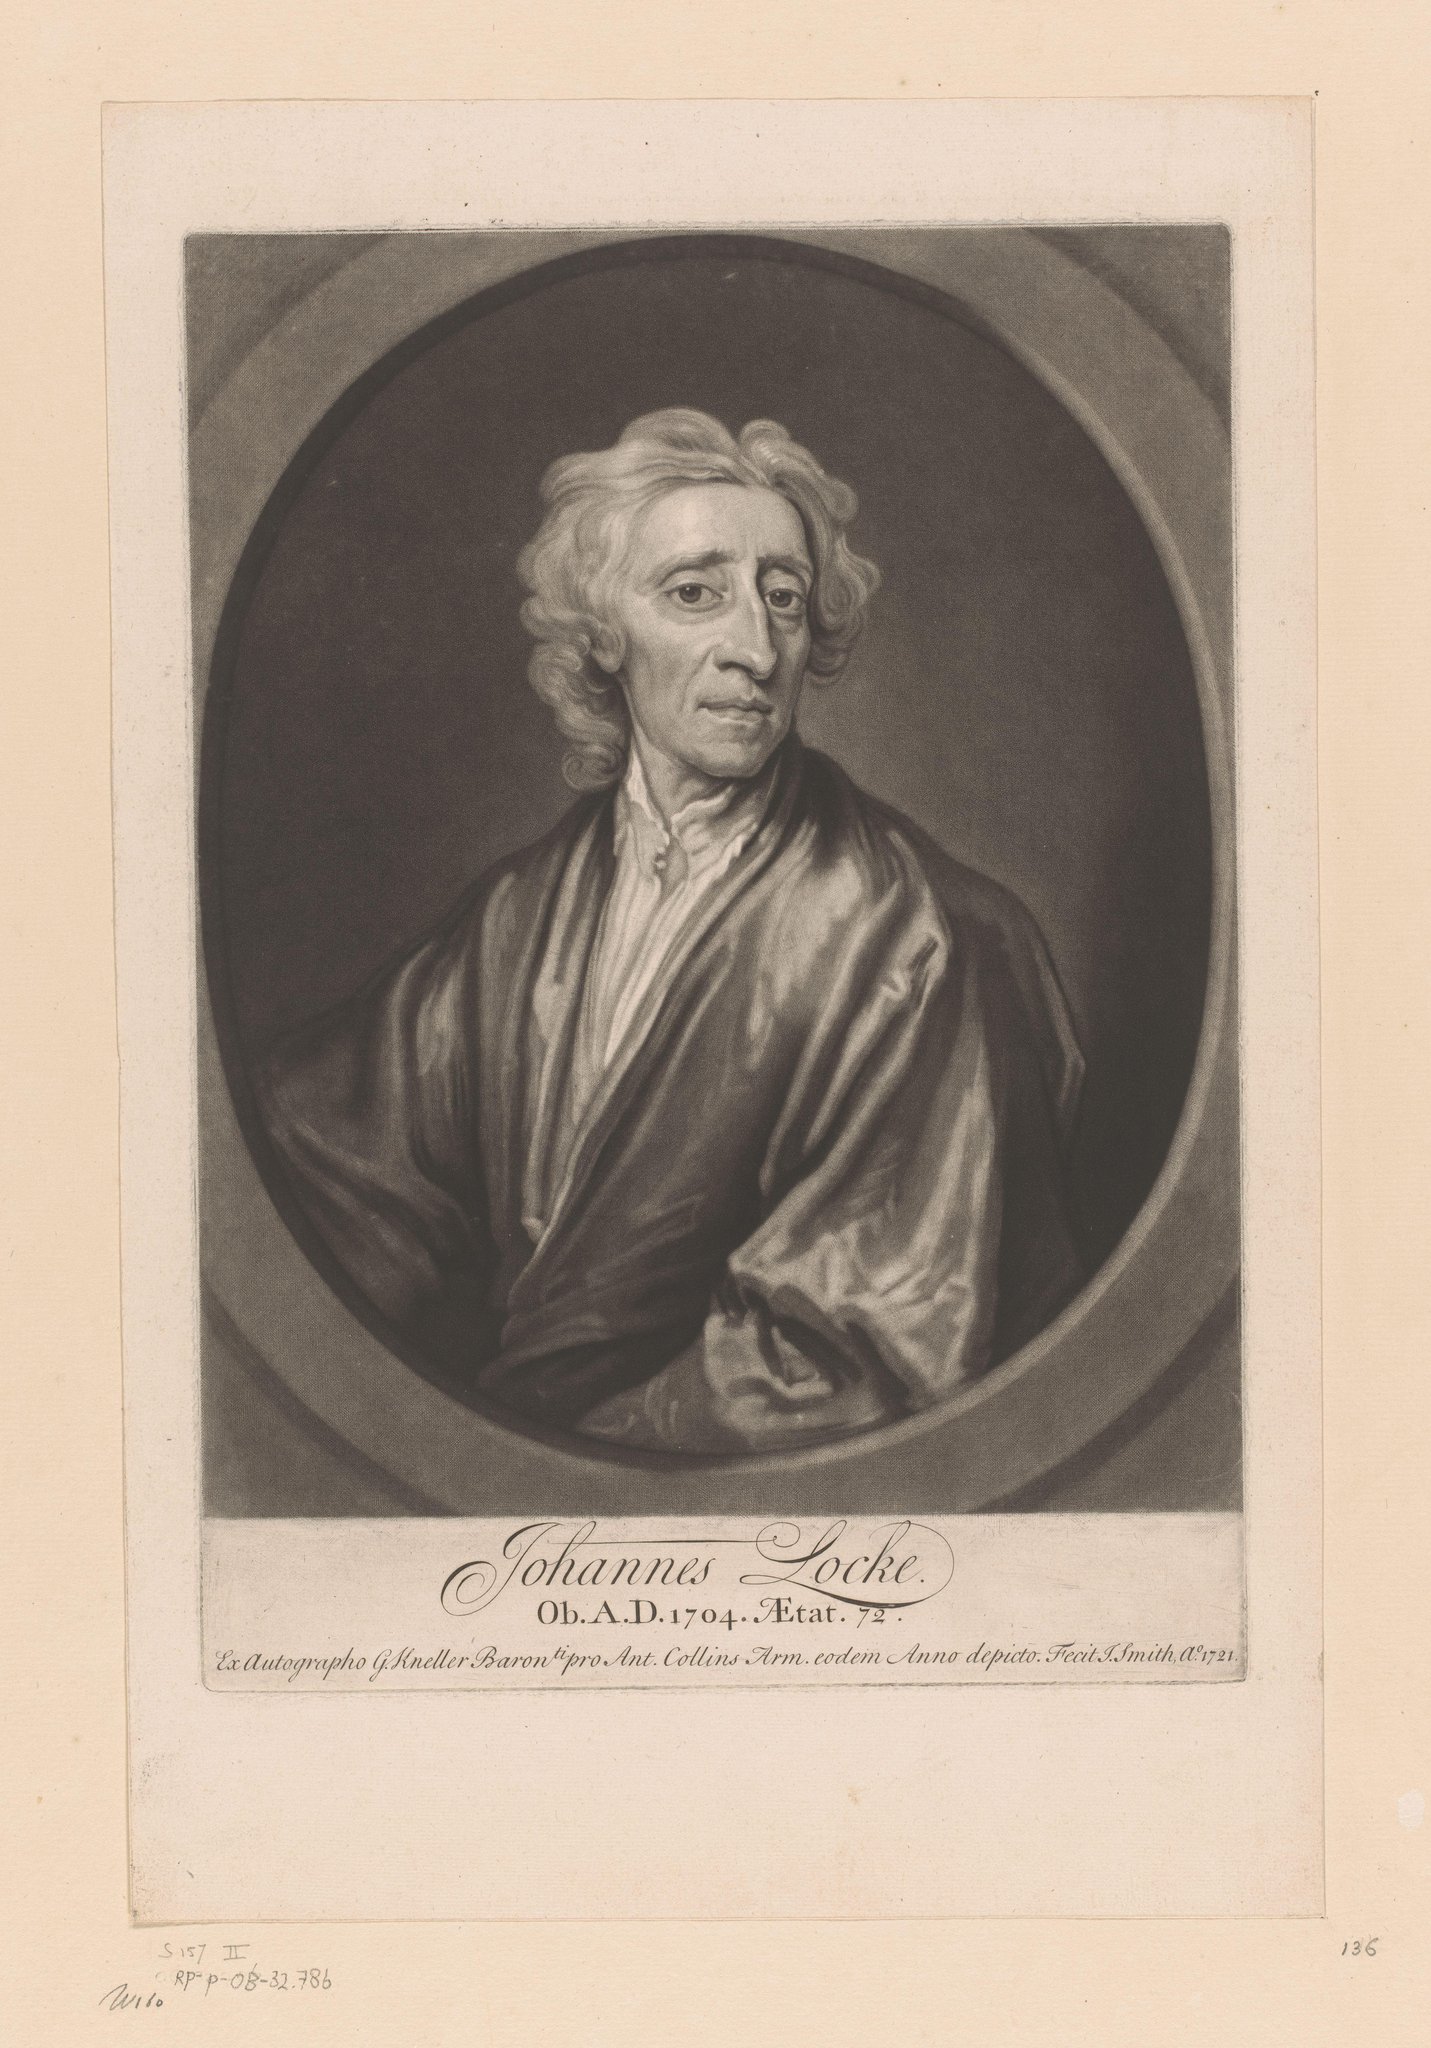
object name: print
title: Portret van John Locke op 72-jarige leeftijd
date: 1721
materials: paper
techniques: mezzotint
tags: politician, historical persons, scholar, philosopher (+ portrait of scholar, scientist)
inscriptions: collector's mark: Lugt 240